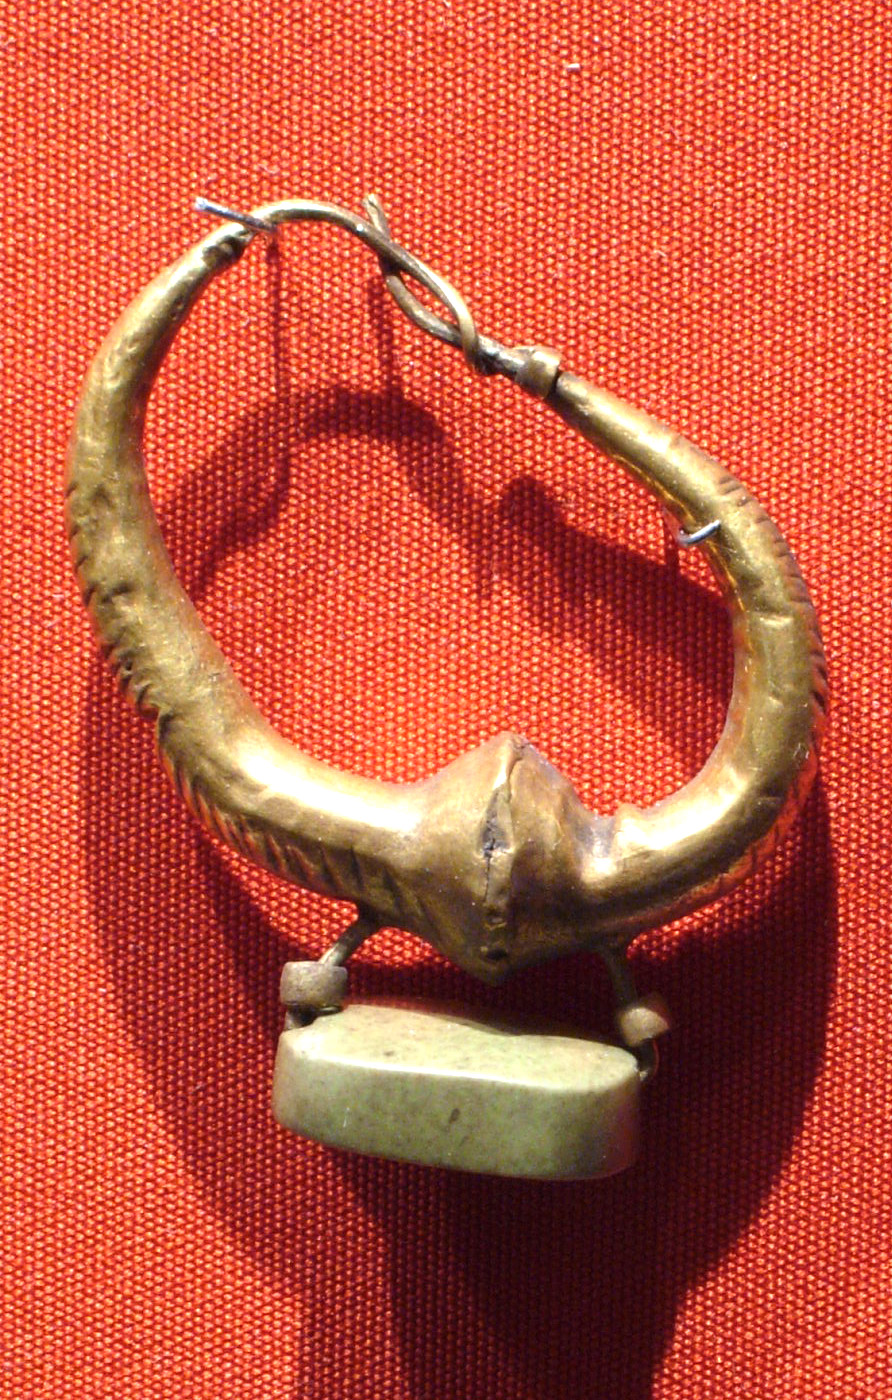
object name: earring, hieroglyphic plaque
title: Ridged earring with an Egyptian Late Period hieroglyphic plaque as ornament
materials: gold, jasper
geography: egypt